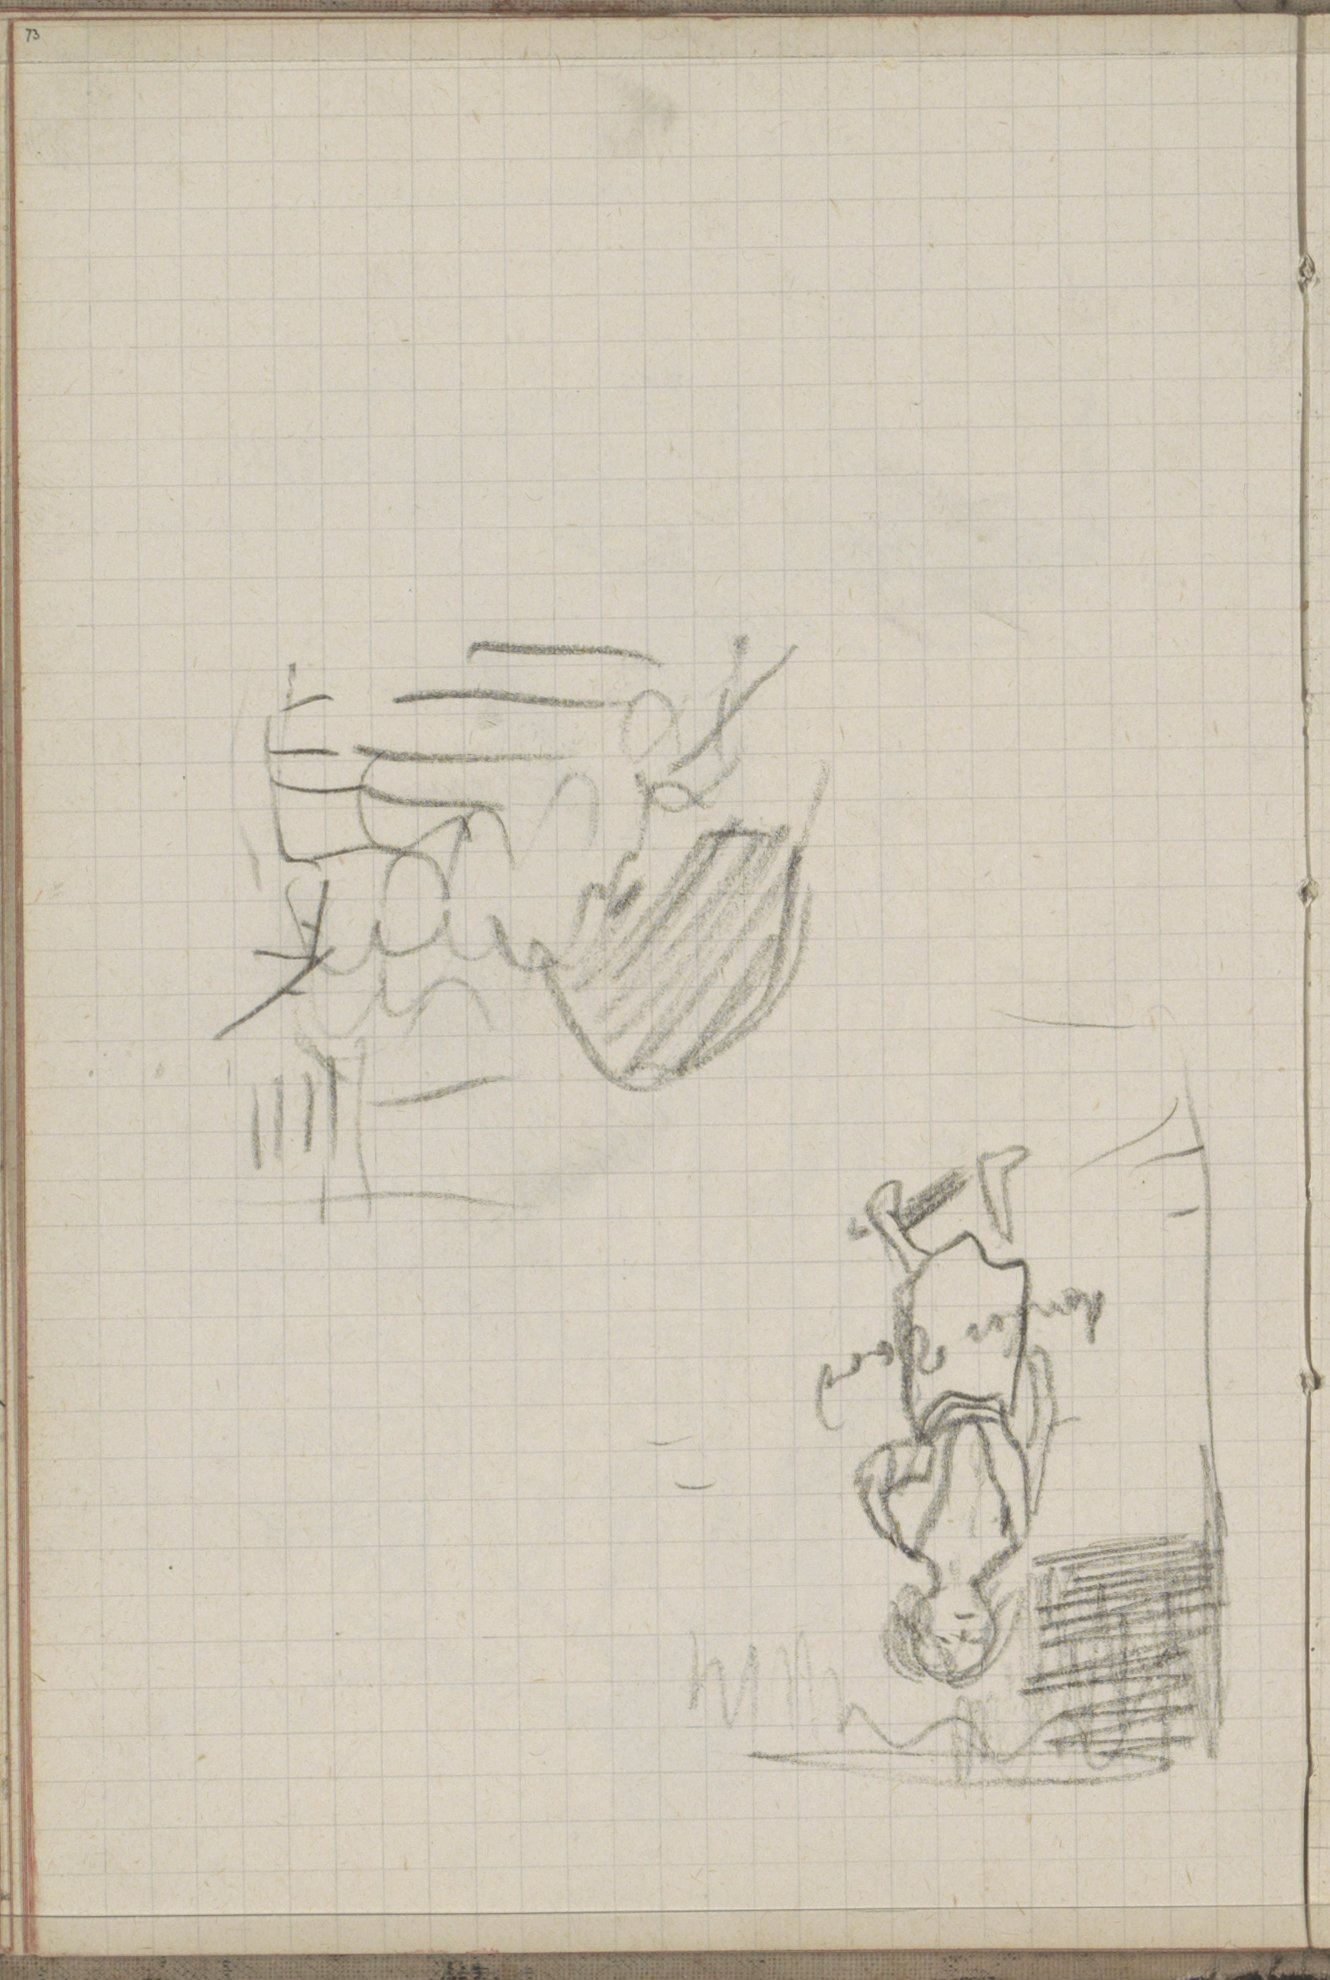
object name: sketchbook leaf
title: Studieblad, onder andere met een kind in oosterse kleding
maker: marius bauer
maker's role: draughtsman, print maker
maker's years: 1867-1932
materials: chalk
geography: istanbul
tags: asiatic races and peoples, child, walking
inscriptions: kleurnotitie, handgeschreven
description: Pagina 73 uit een schetsboek met 54 bladen.